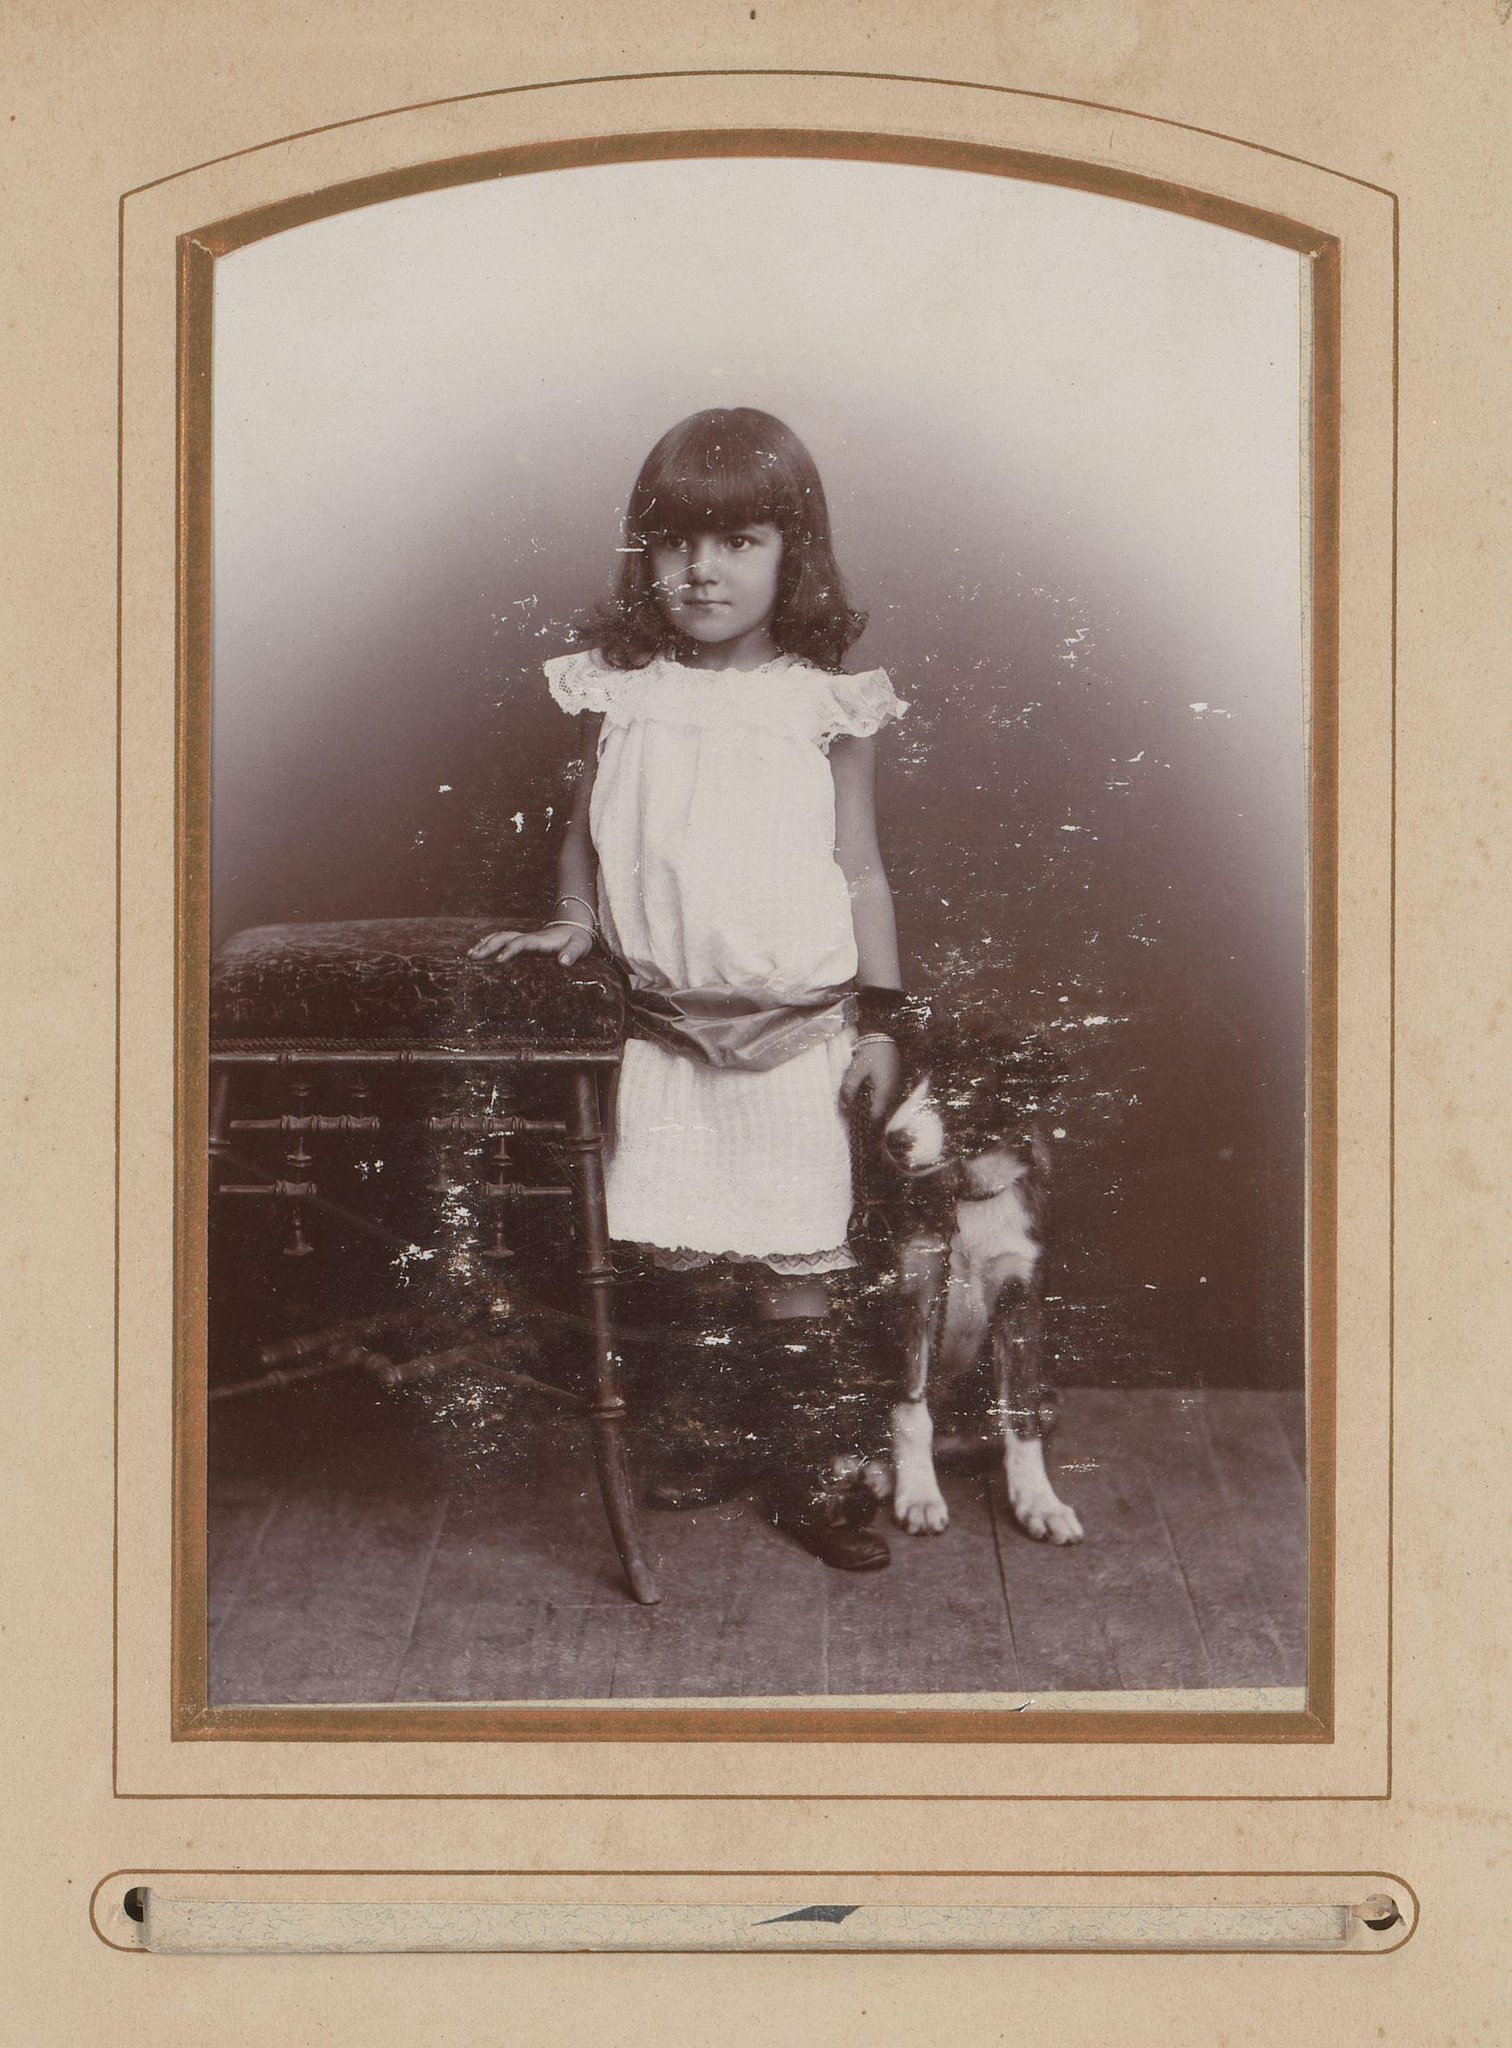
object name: album leaf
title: Portret van een staand meisje in witte jurk en een hond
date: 1884-1887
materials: cardboard, photographic support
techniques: collodion silver print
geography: surabaya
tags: historical persons - bb - woman, girl (child between toddler and youth), dog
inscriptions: inscription: ‘Bekroond met Zilver./ Photographie/ Instantanée/ Charls & van Es/ hofphotographen./ Soerabaia./ Photografieen in alle formaten./ Kooldruk op papier en porcelein, Platinotypie/ en Vergrootingen op Eastmanpapier etc. etc./ Het cliché wordt voor Nabestelling bewaard.’